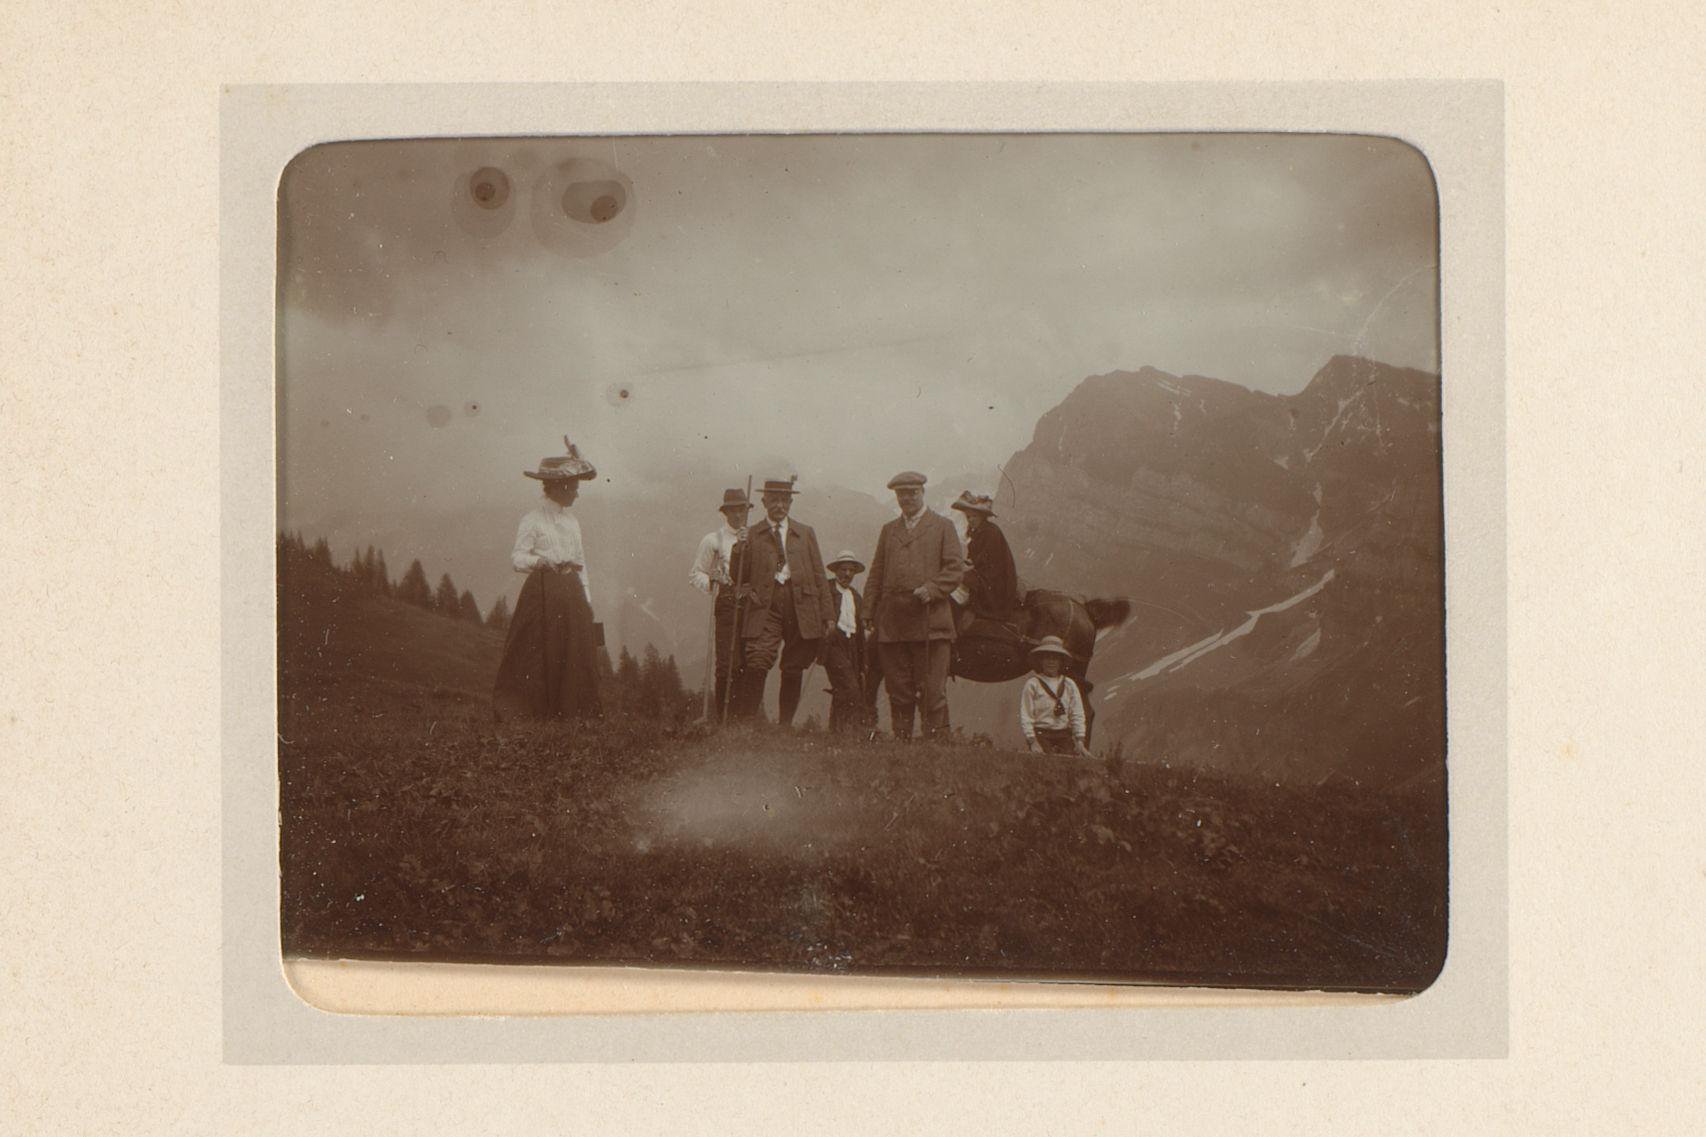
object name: album leaf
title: Gezelschap in de bergen, waarvan een te paard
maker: liesbeth overhoff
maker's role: fotograaf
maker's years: 1895-1969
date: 1911-1912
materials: paper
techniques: gelatin silver print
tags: riding a horse, ass, or mule; rider, horseman, historical persons, mountains